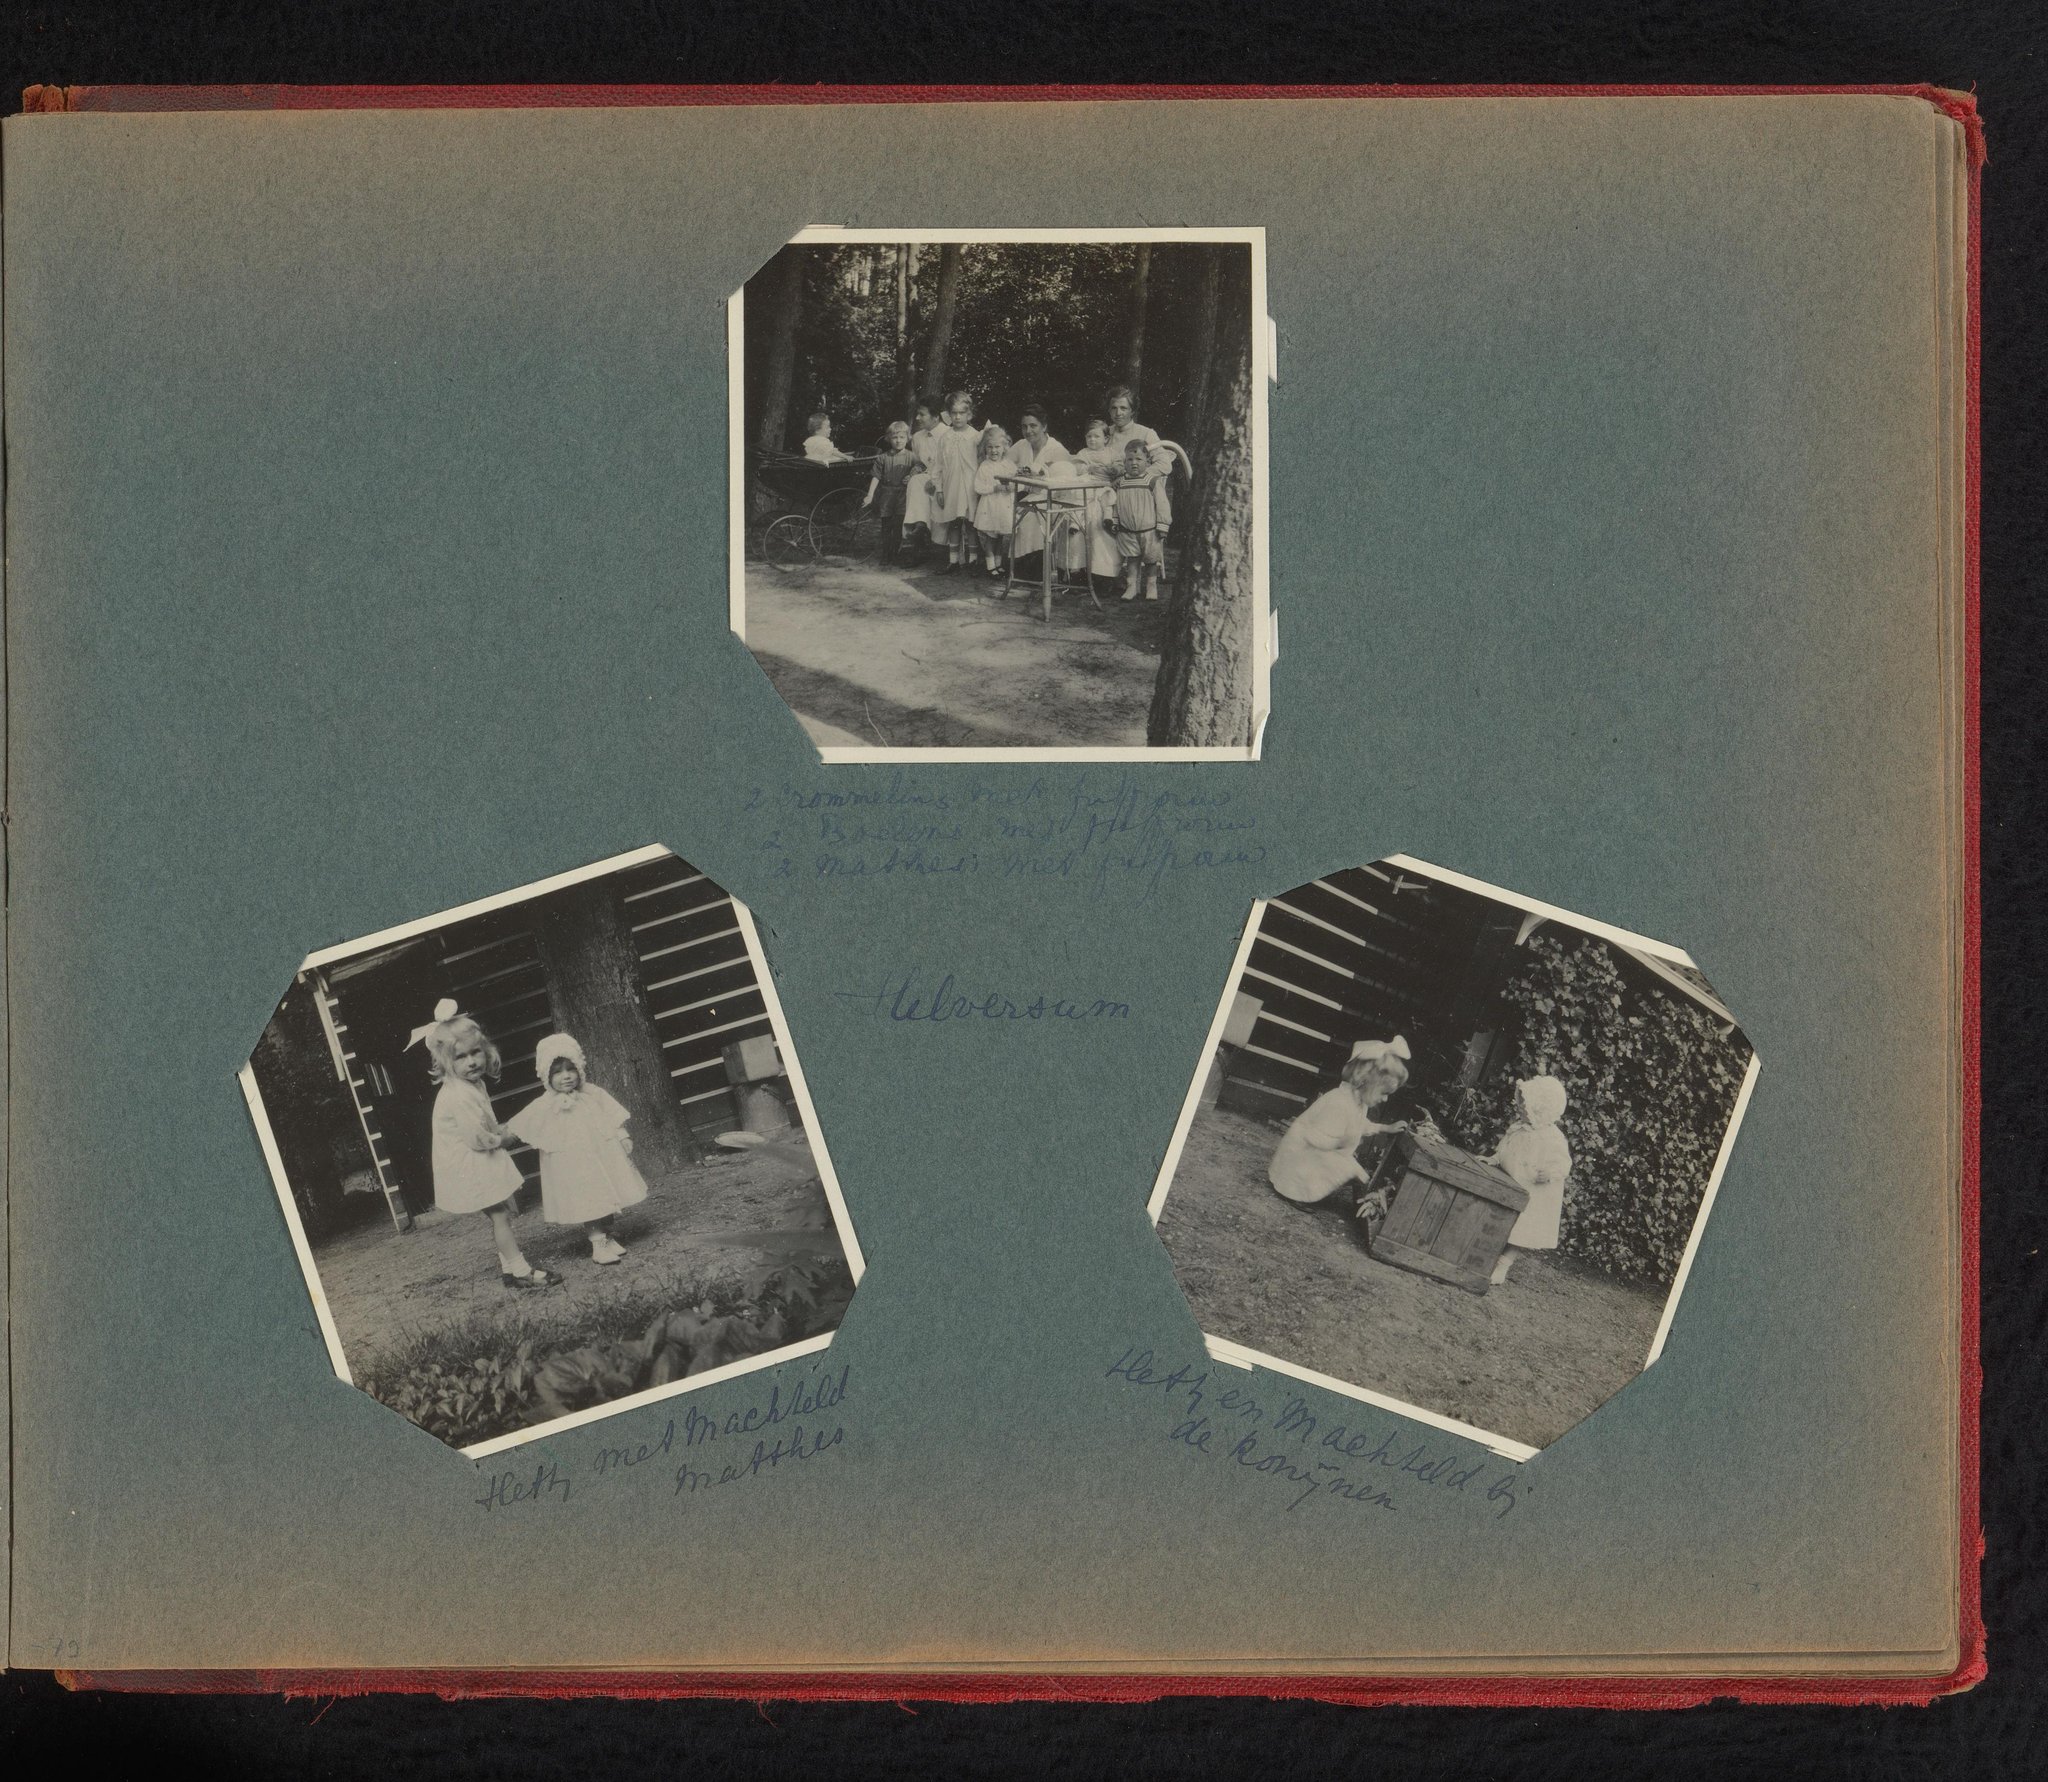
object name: photograph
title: Hilversum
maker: charlotte alida boelen-matthes (lot)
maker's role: amateurfotograaf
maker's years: 1889-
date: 1918-1919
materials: paper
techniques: gelatin silver print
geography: hilversum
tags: garden, cousins (third degree family relationships)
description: Deze foto's zijn onderdeel van een album.